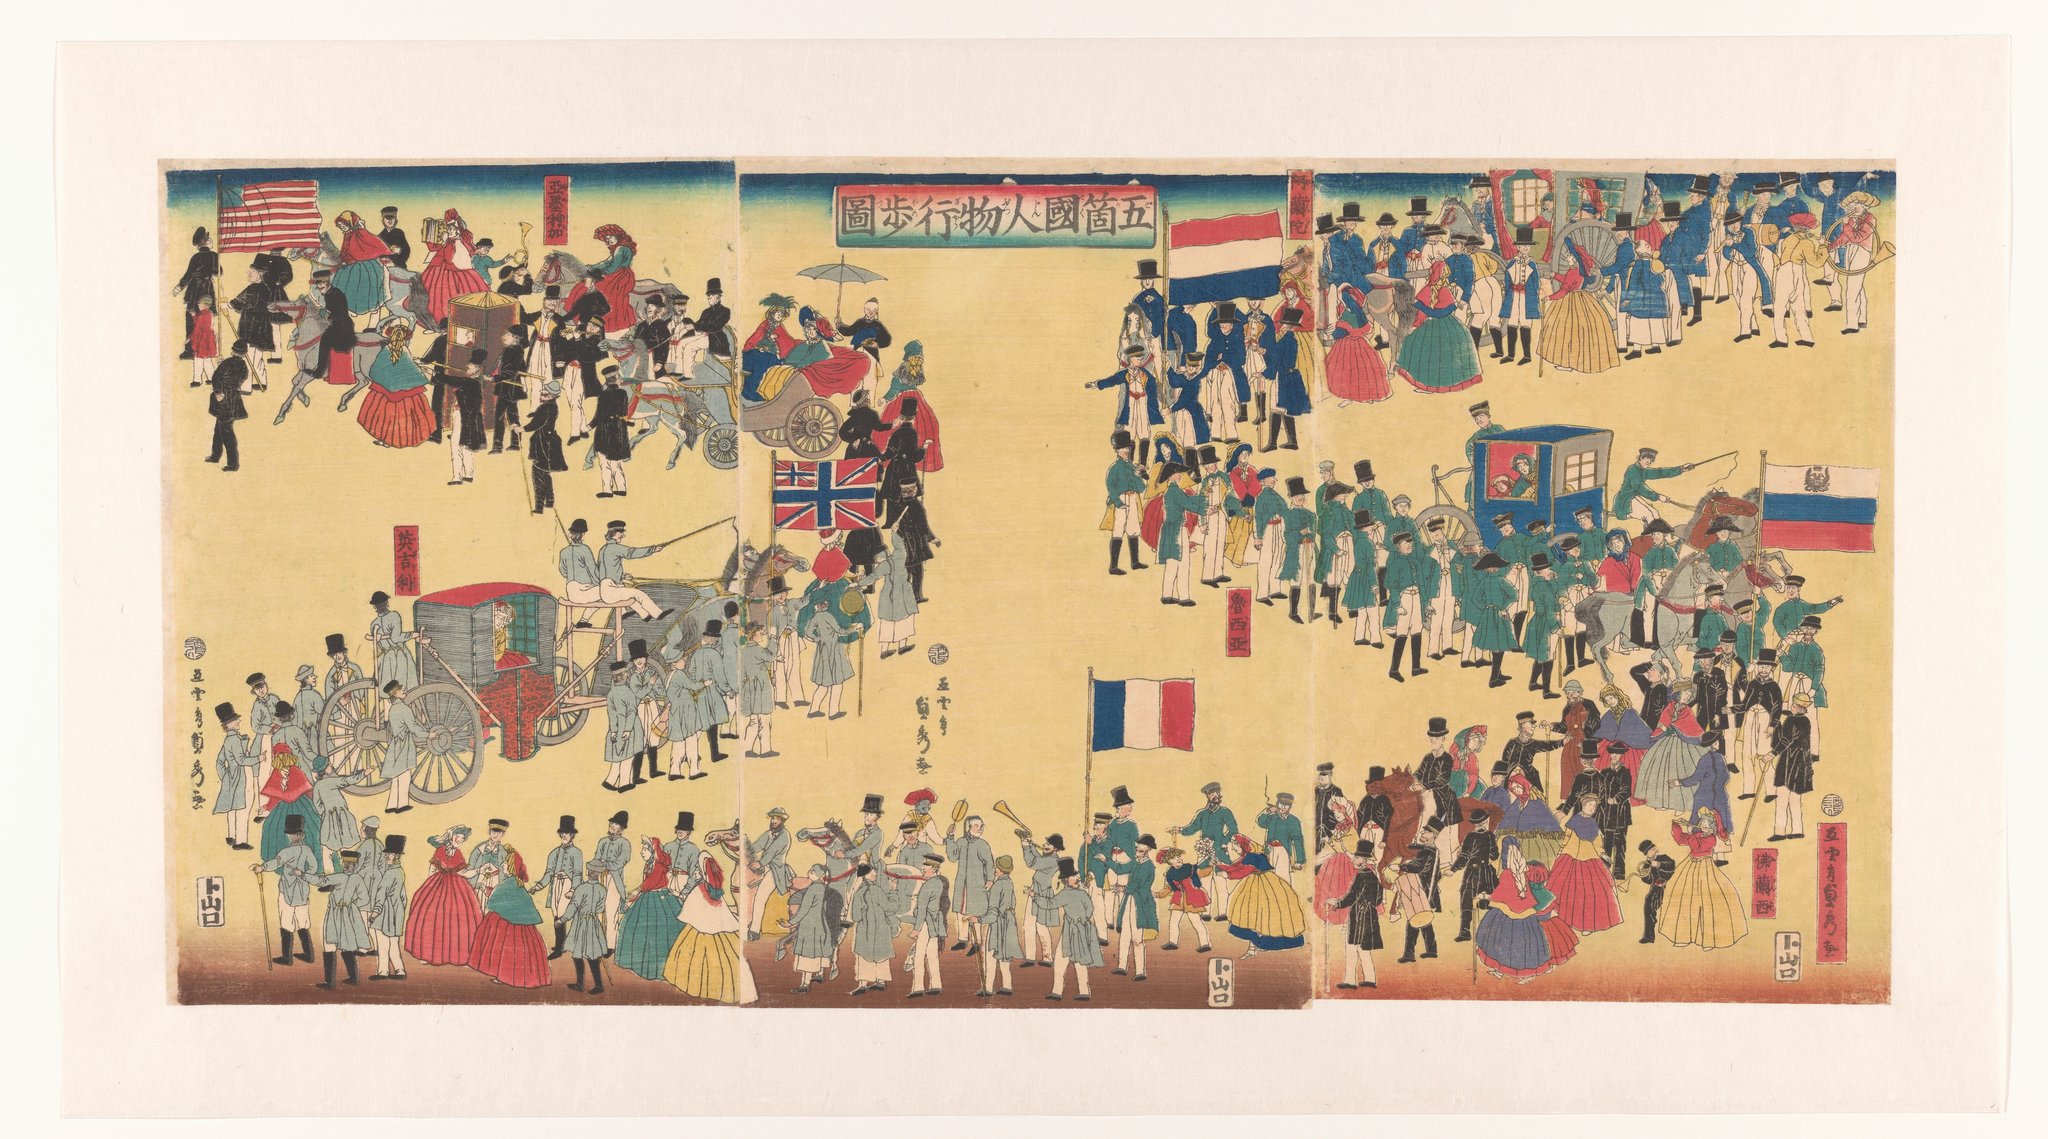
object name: print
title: Optocht van mensen uit de Vijf Landen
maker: utagawa sadahide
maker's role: draughtsman, print maker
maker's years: 1807-1873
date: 1803-1861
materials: paper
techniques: woodcut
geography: japan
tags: non-european white peoples: americans, europeans: englishmen, europeans (with name), rejoicing on special occasions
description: Slingerende optocht van mensen uit Amerika, Engeland, Frankrijk Rusland en Nederland. Deze vijf landen hadden een handelsverdrag met Japan en mochten afgevaardigden in Yokohama laten wonen. (Yokohama-e triptiek).